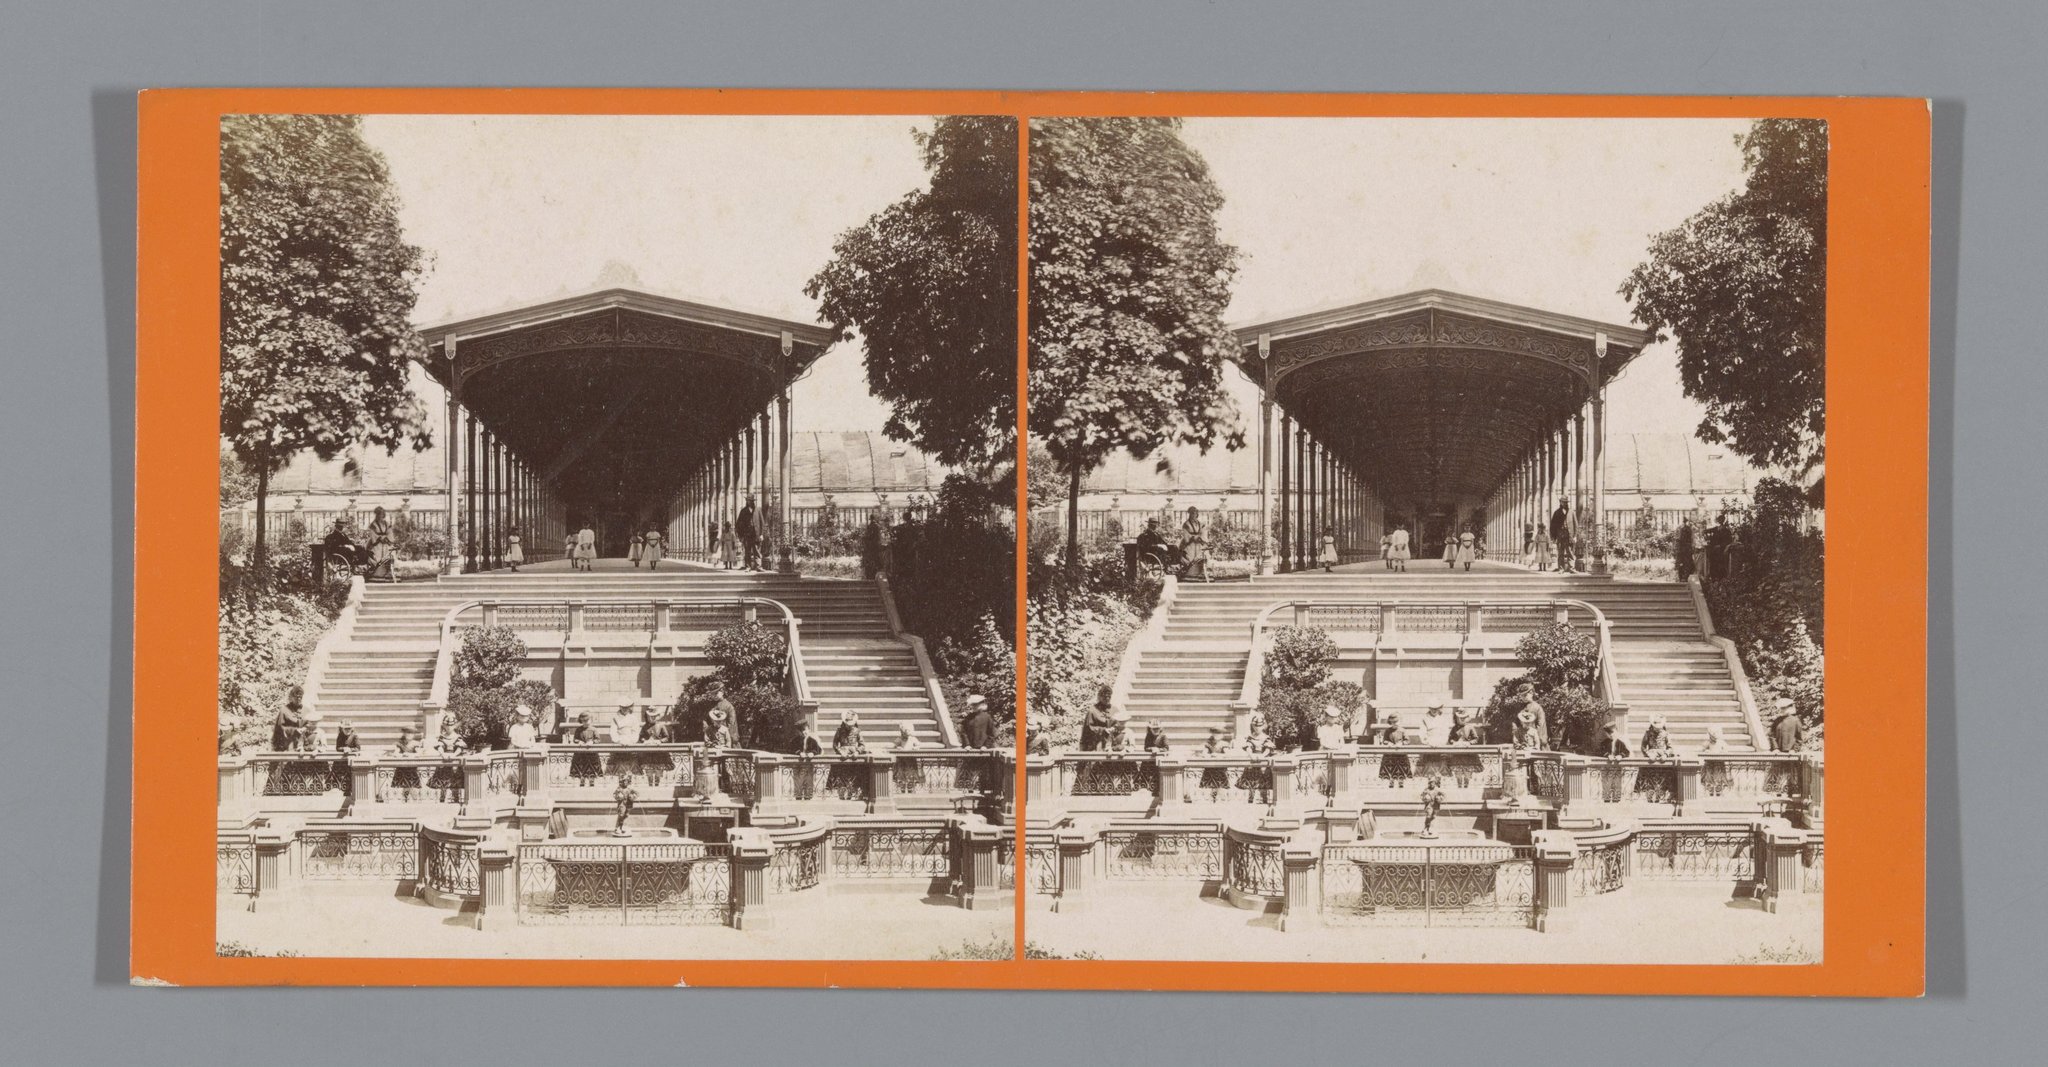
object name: stereograph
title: Overkoepeld pad bij de Elisabethenbrunnen te Bad Homburg vor der Höhe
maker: františek fridrich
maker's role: publisher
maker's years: 1829-1892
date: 1855-1870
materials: cardboard, photographic support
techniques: albumen print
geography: bad homburg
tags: watering-place, spa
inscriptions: number: ‘3.’